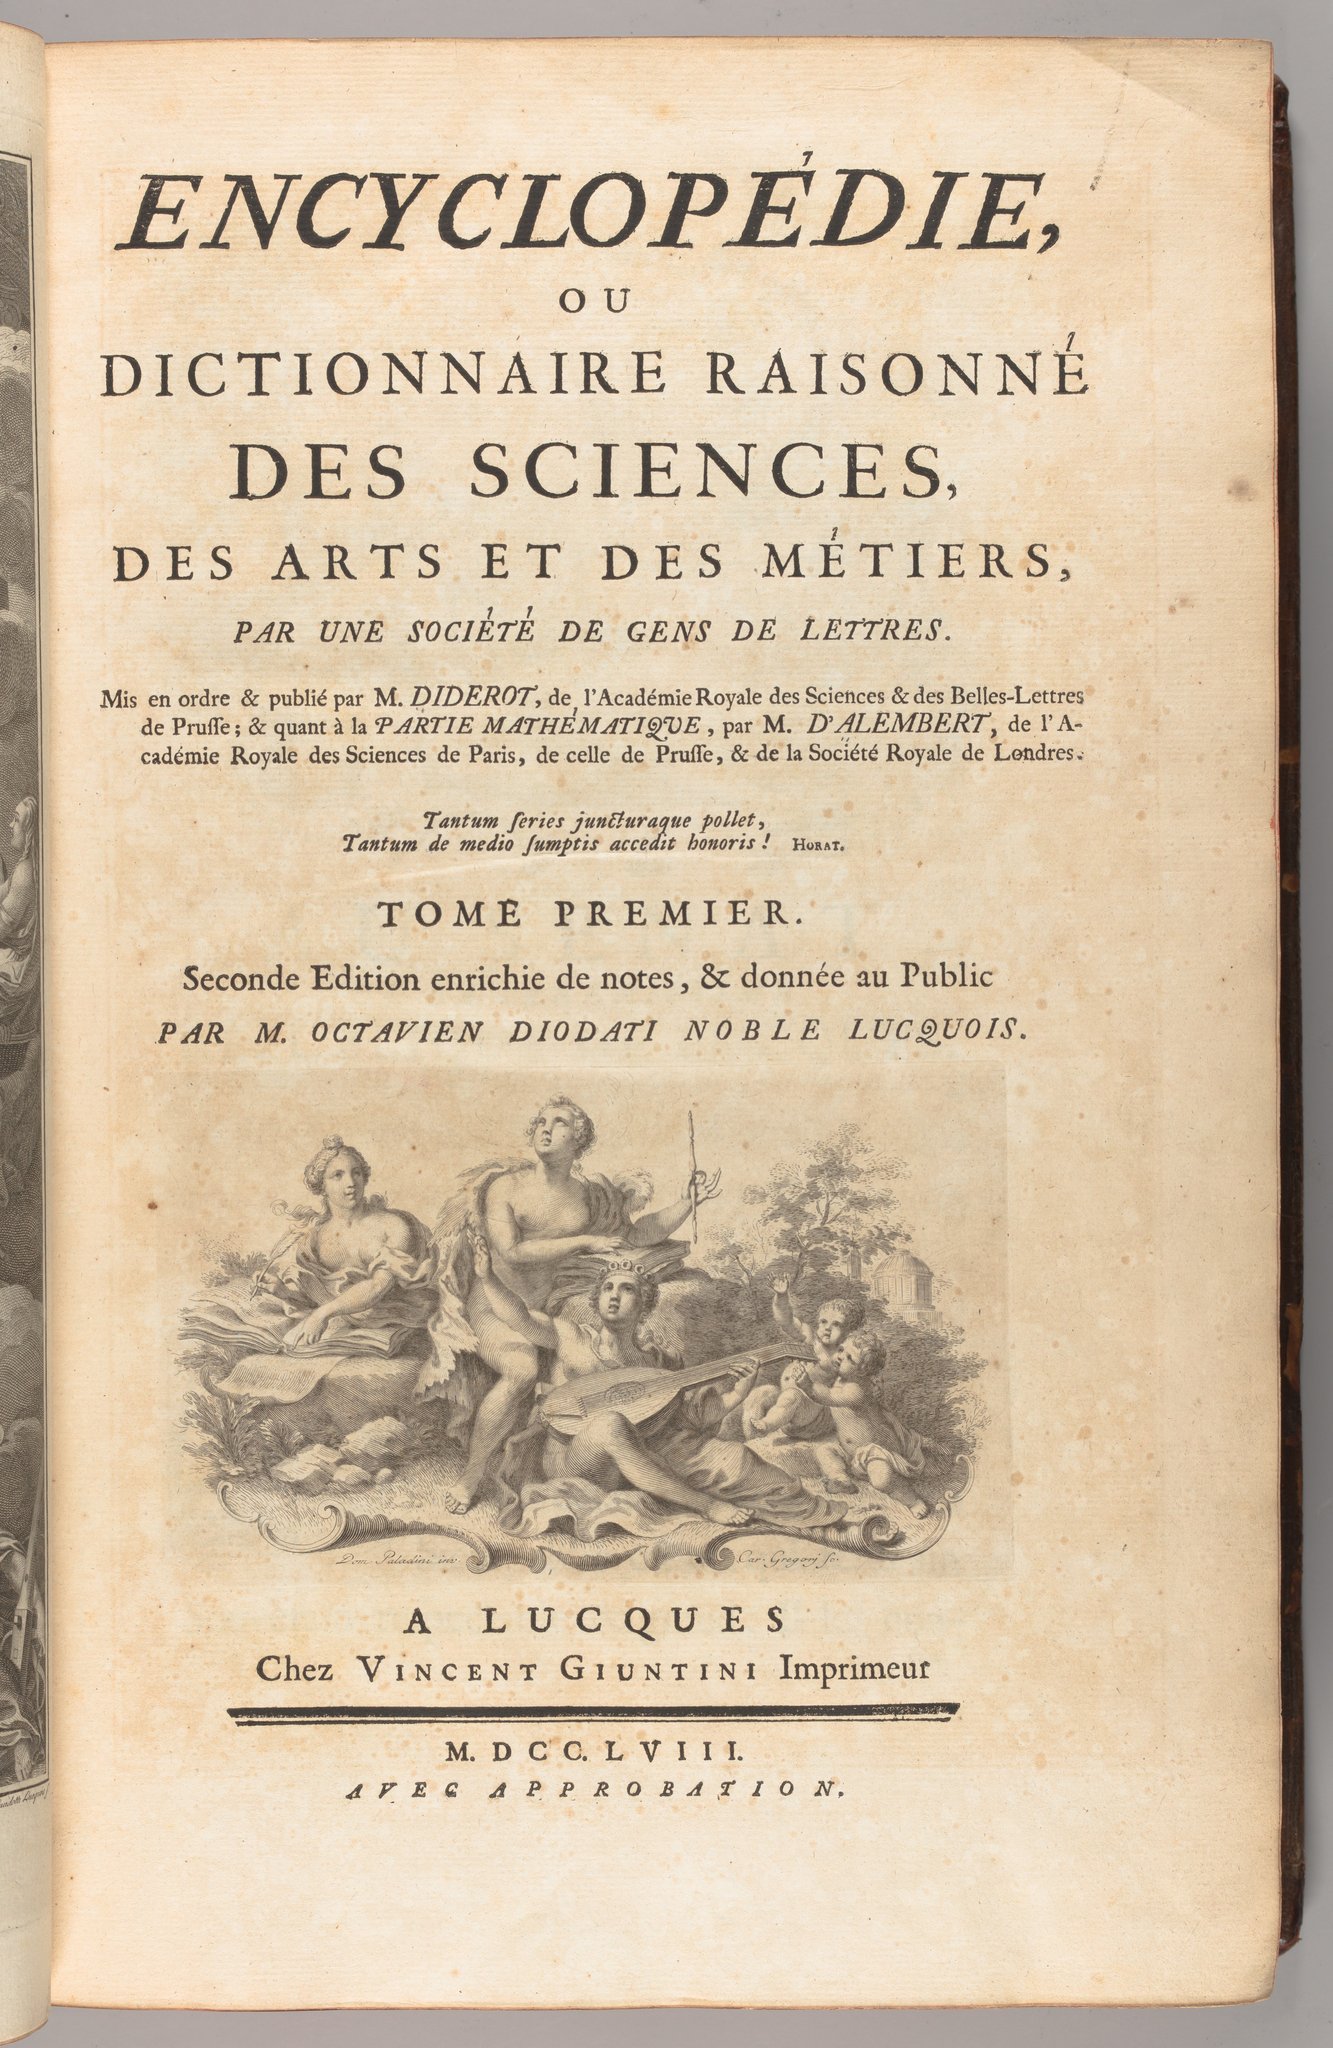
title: Encyclopédie, ou Dictionnaire raisonné des sciences, des arts et des métiers, par une société de gens de lettres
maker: denis diderot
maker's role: author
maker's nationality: french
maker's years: 1713-1784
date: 1758-1771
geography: italy